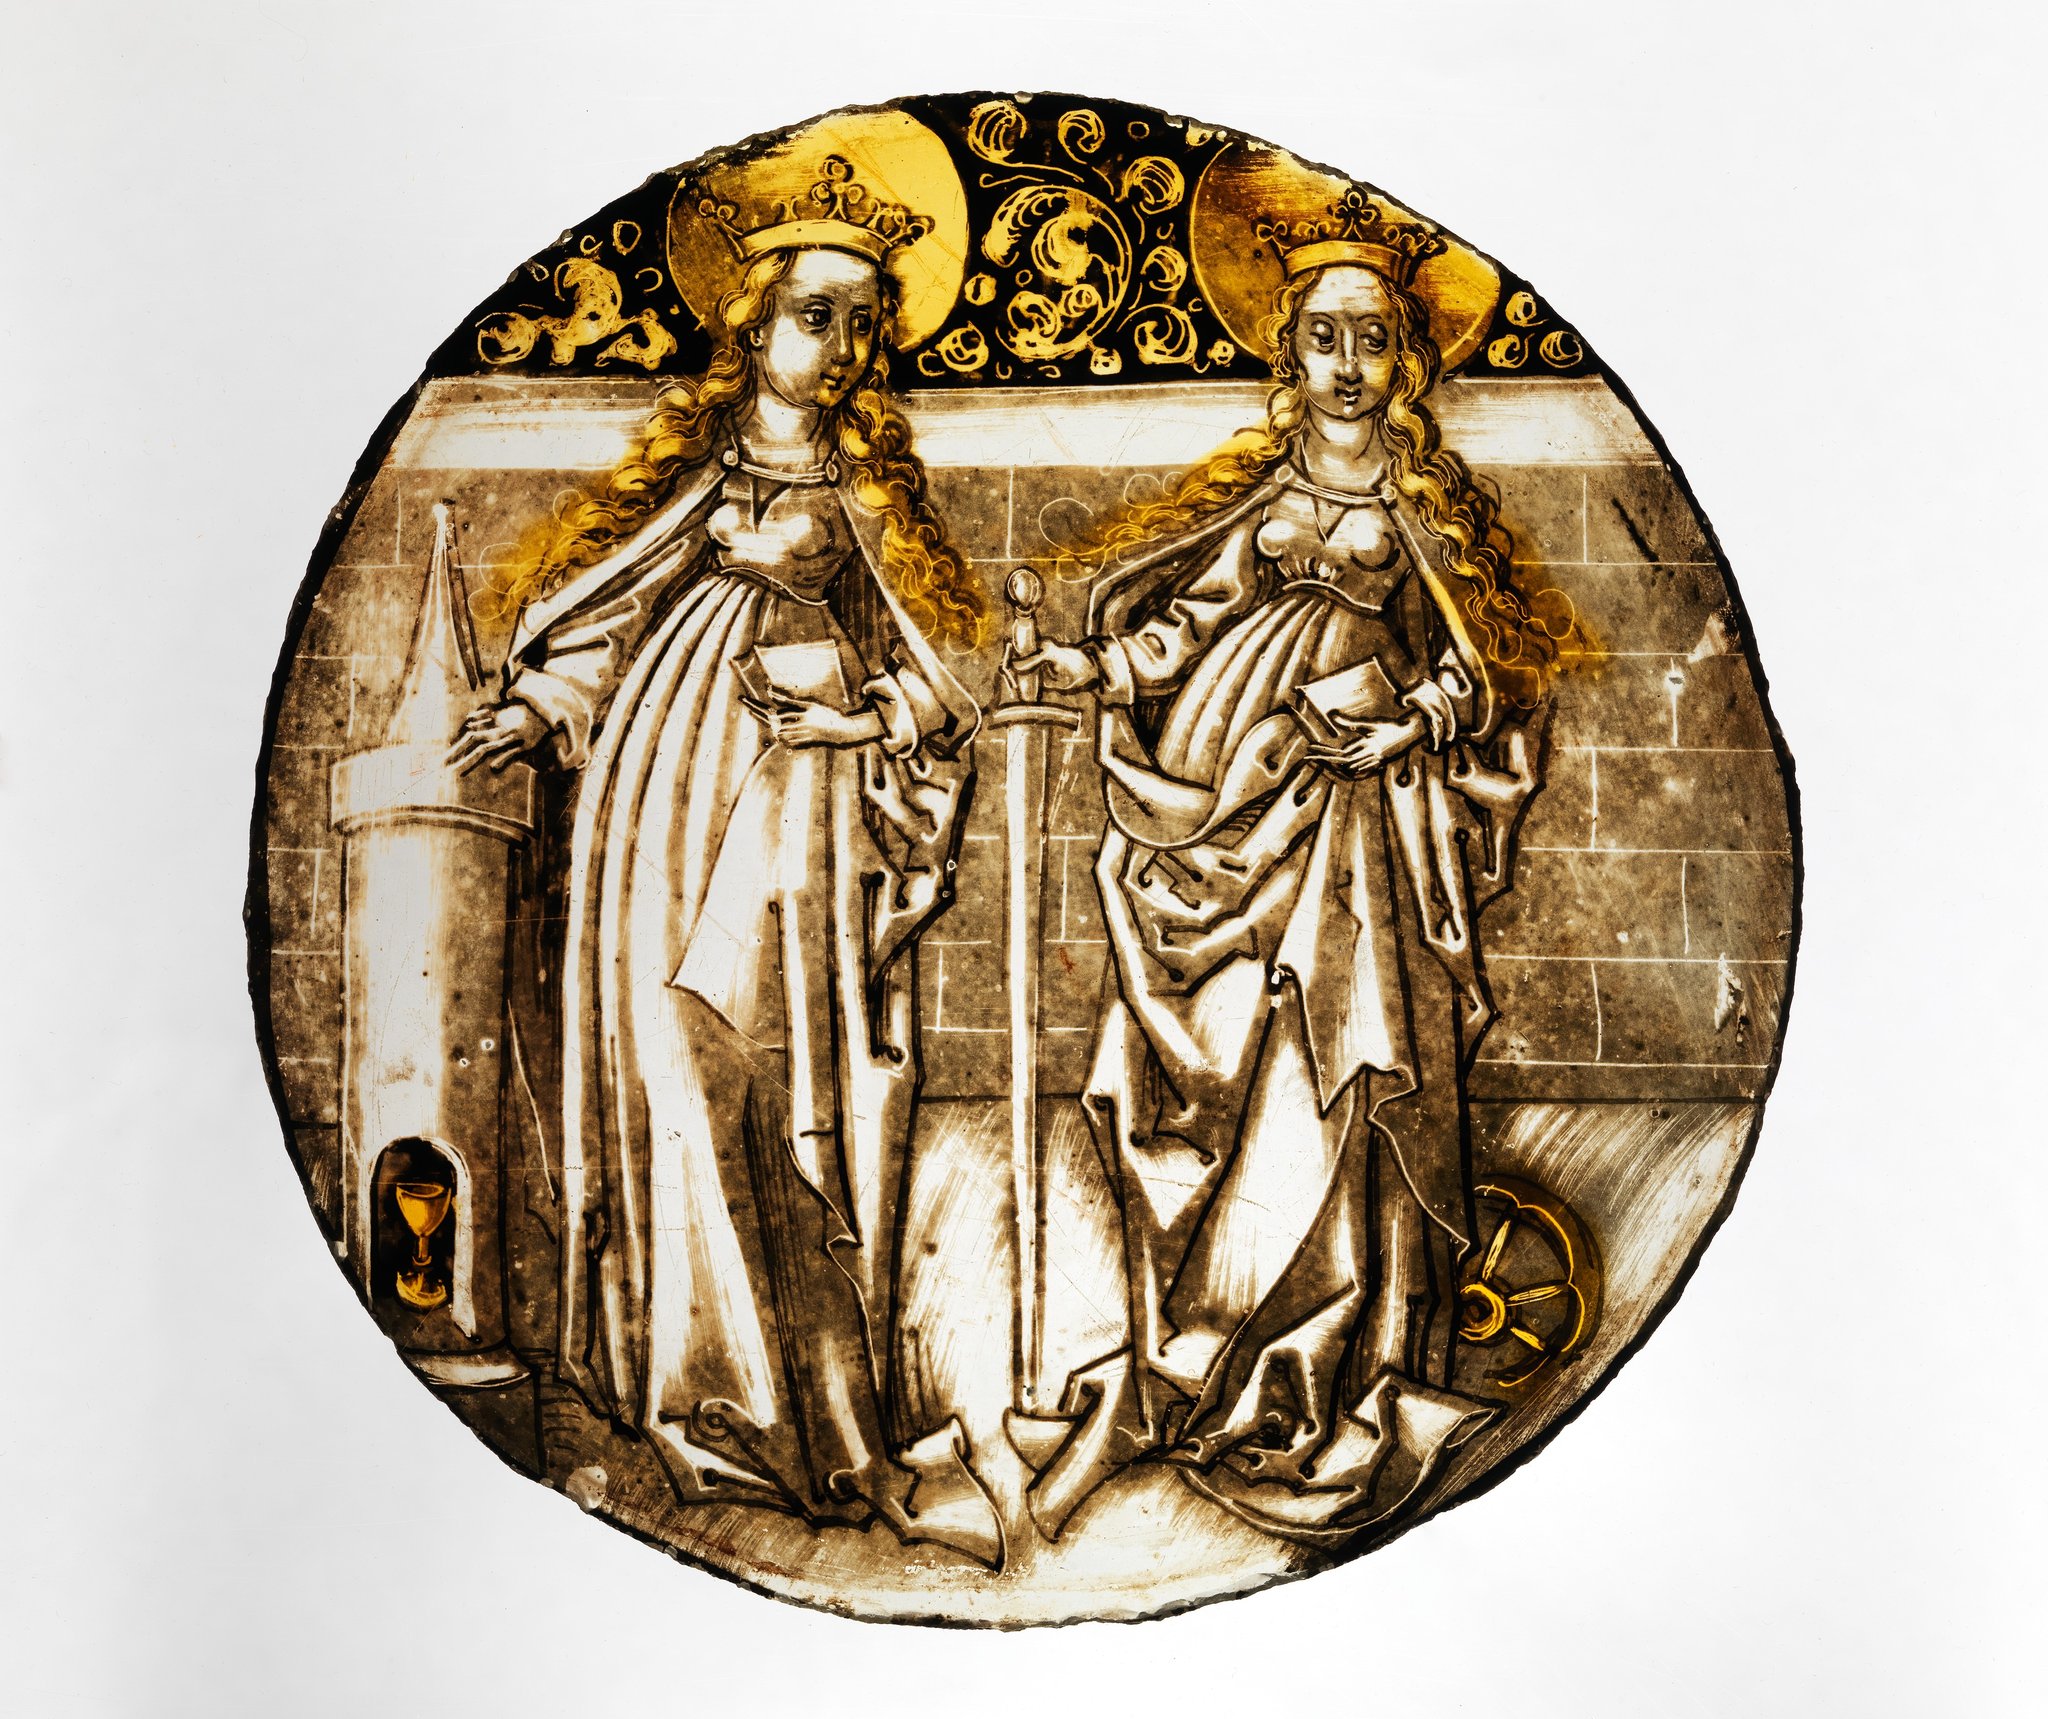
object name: roundel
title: Roundel with Saints Barbara and Catherine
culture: german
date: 1500-1510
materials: glass, paint, pigment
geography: germany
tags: women,saint catherine,saints